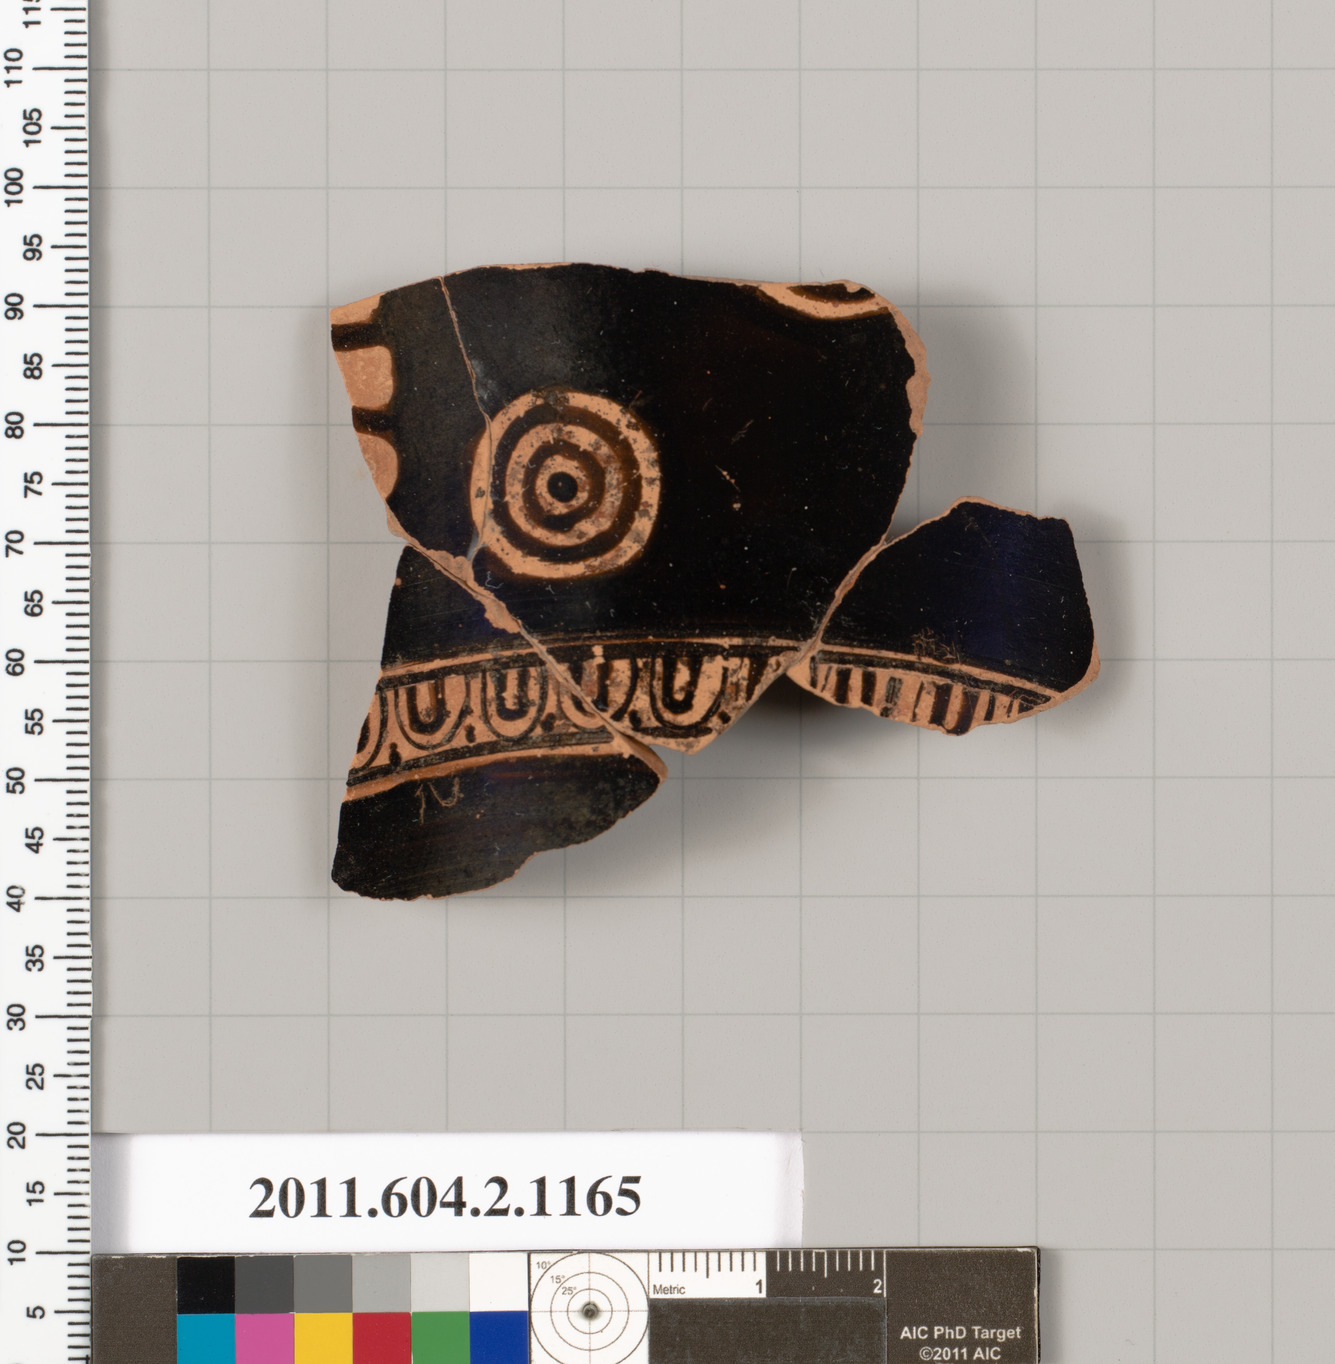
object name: skyphos fragment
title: Terracotta fragment of a skyphos (deep drinking cup)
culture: greek, attic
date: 460-440 BCE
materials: terracotta